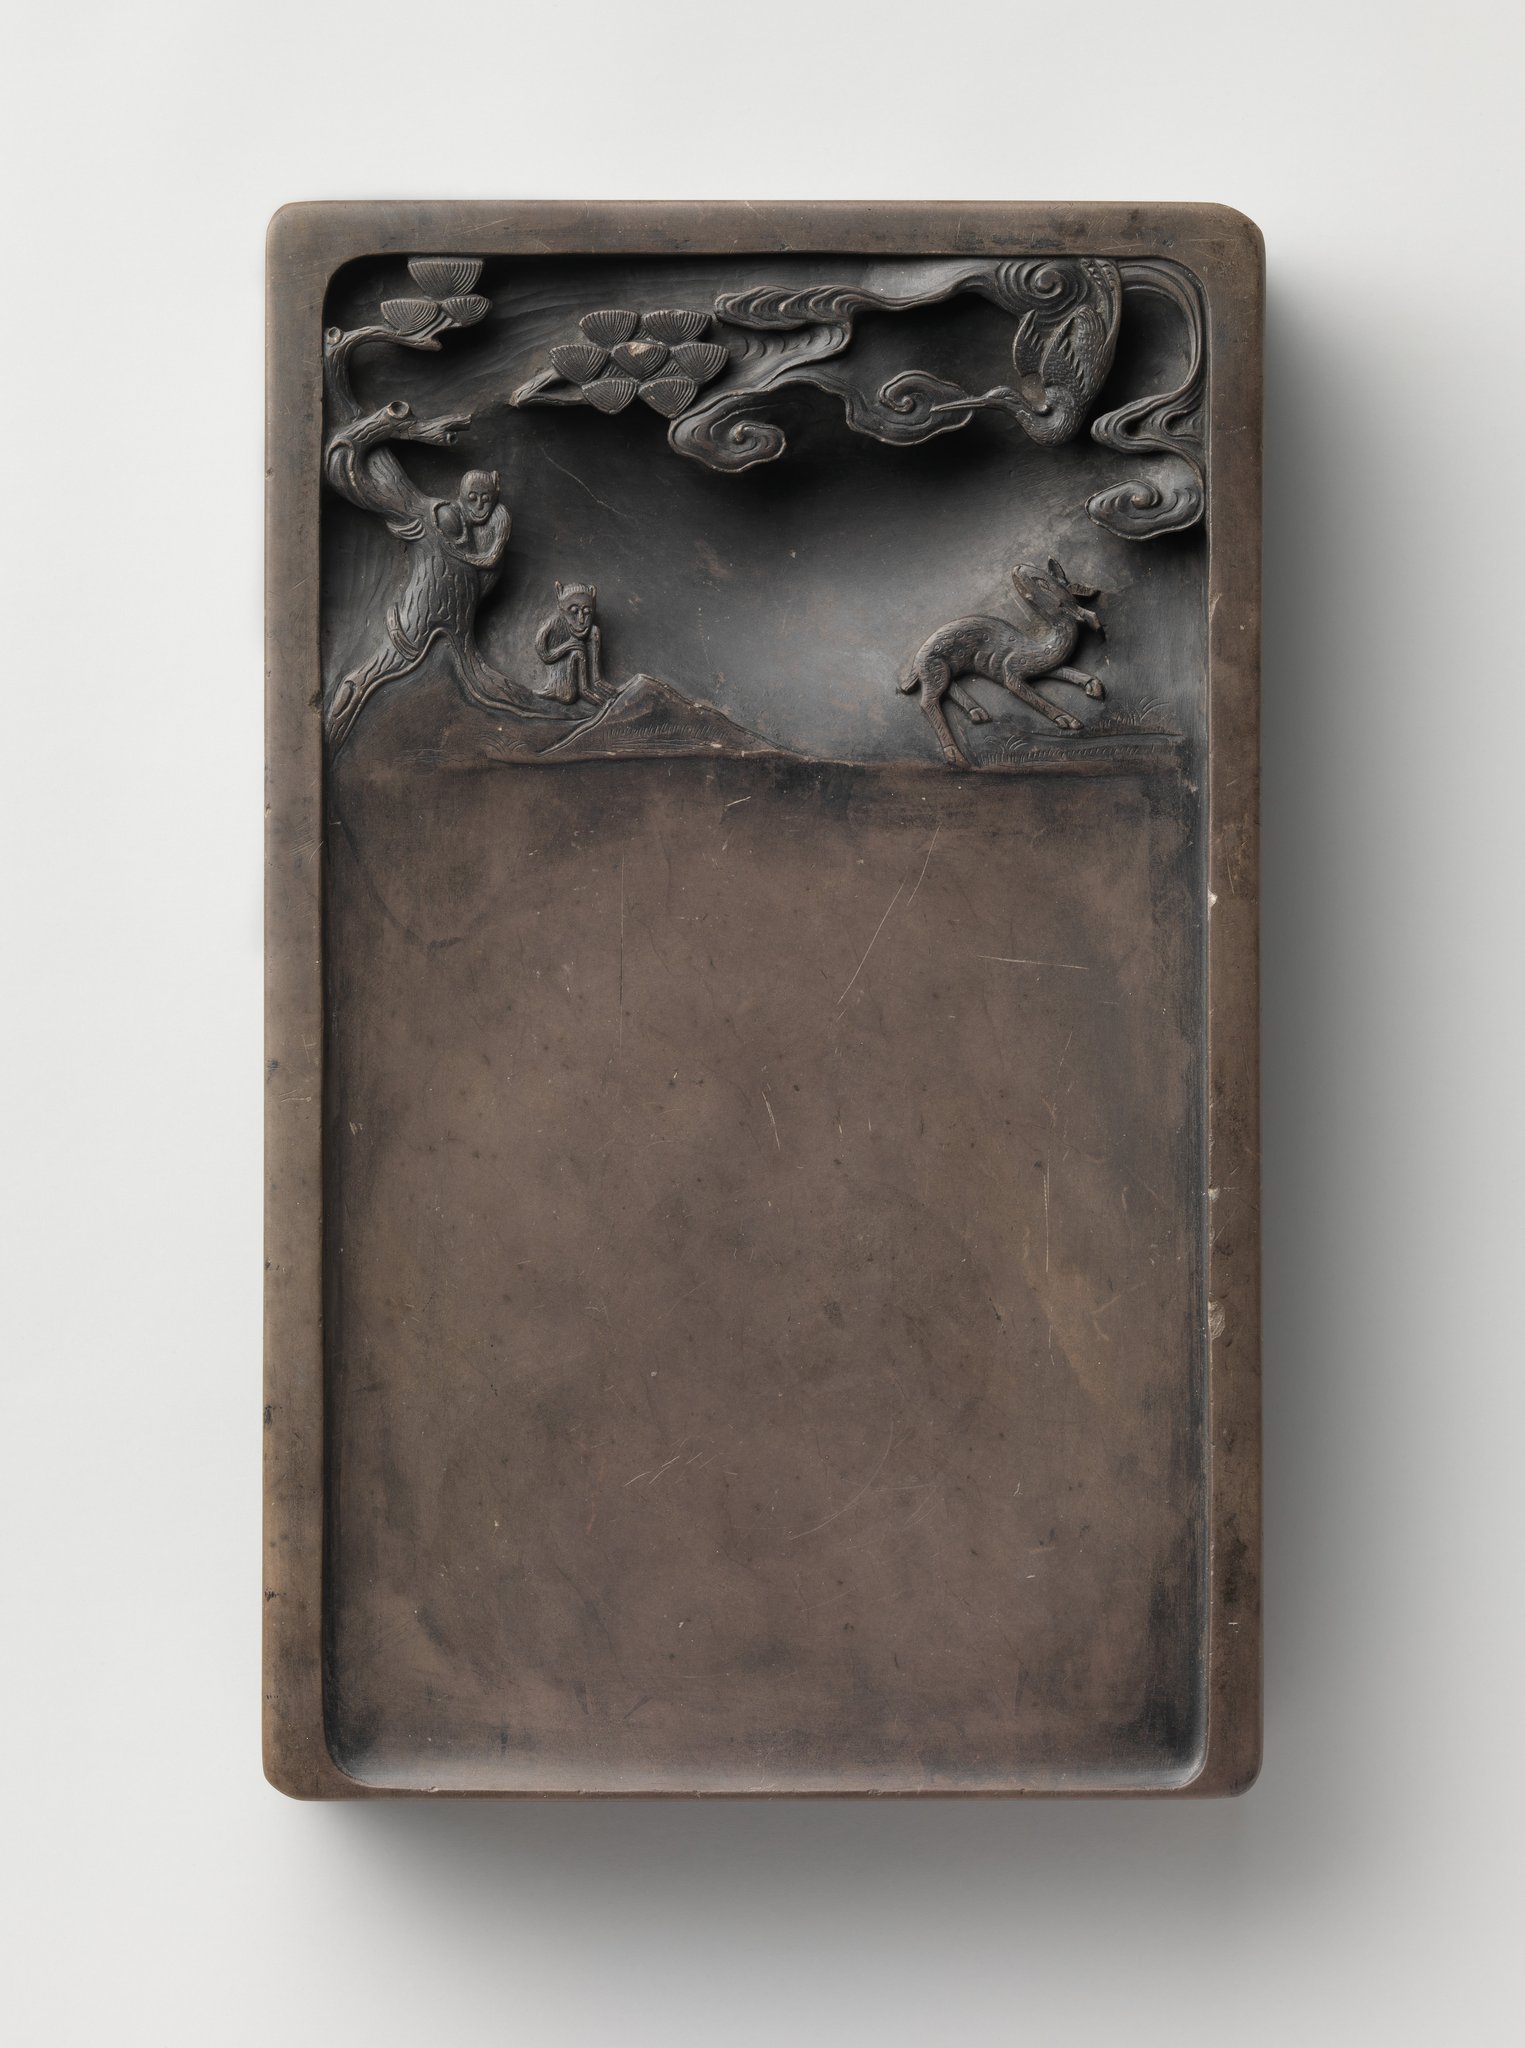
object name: inkstone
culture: chinese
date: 1644-1911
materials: stone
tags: cranes,deer,monkeys